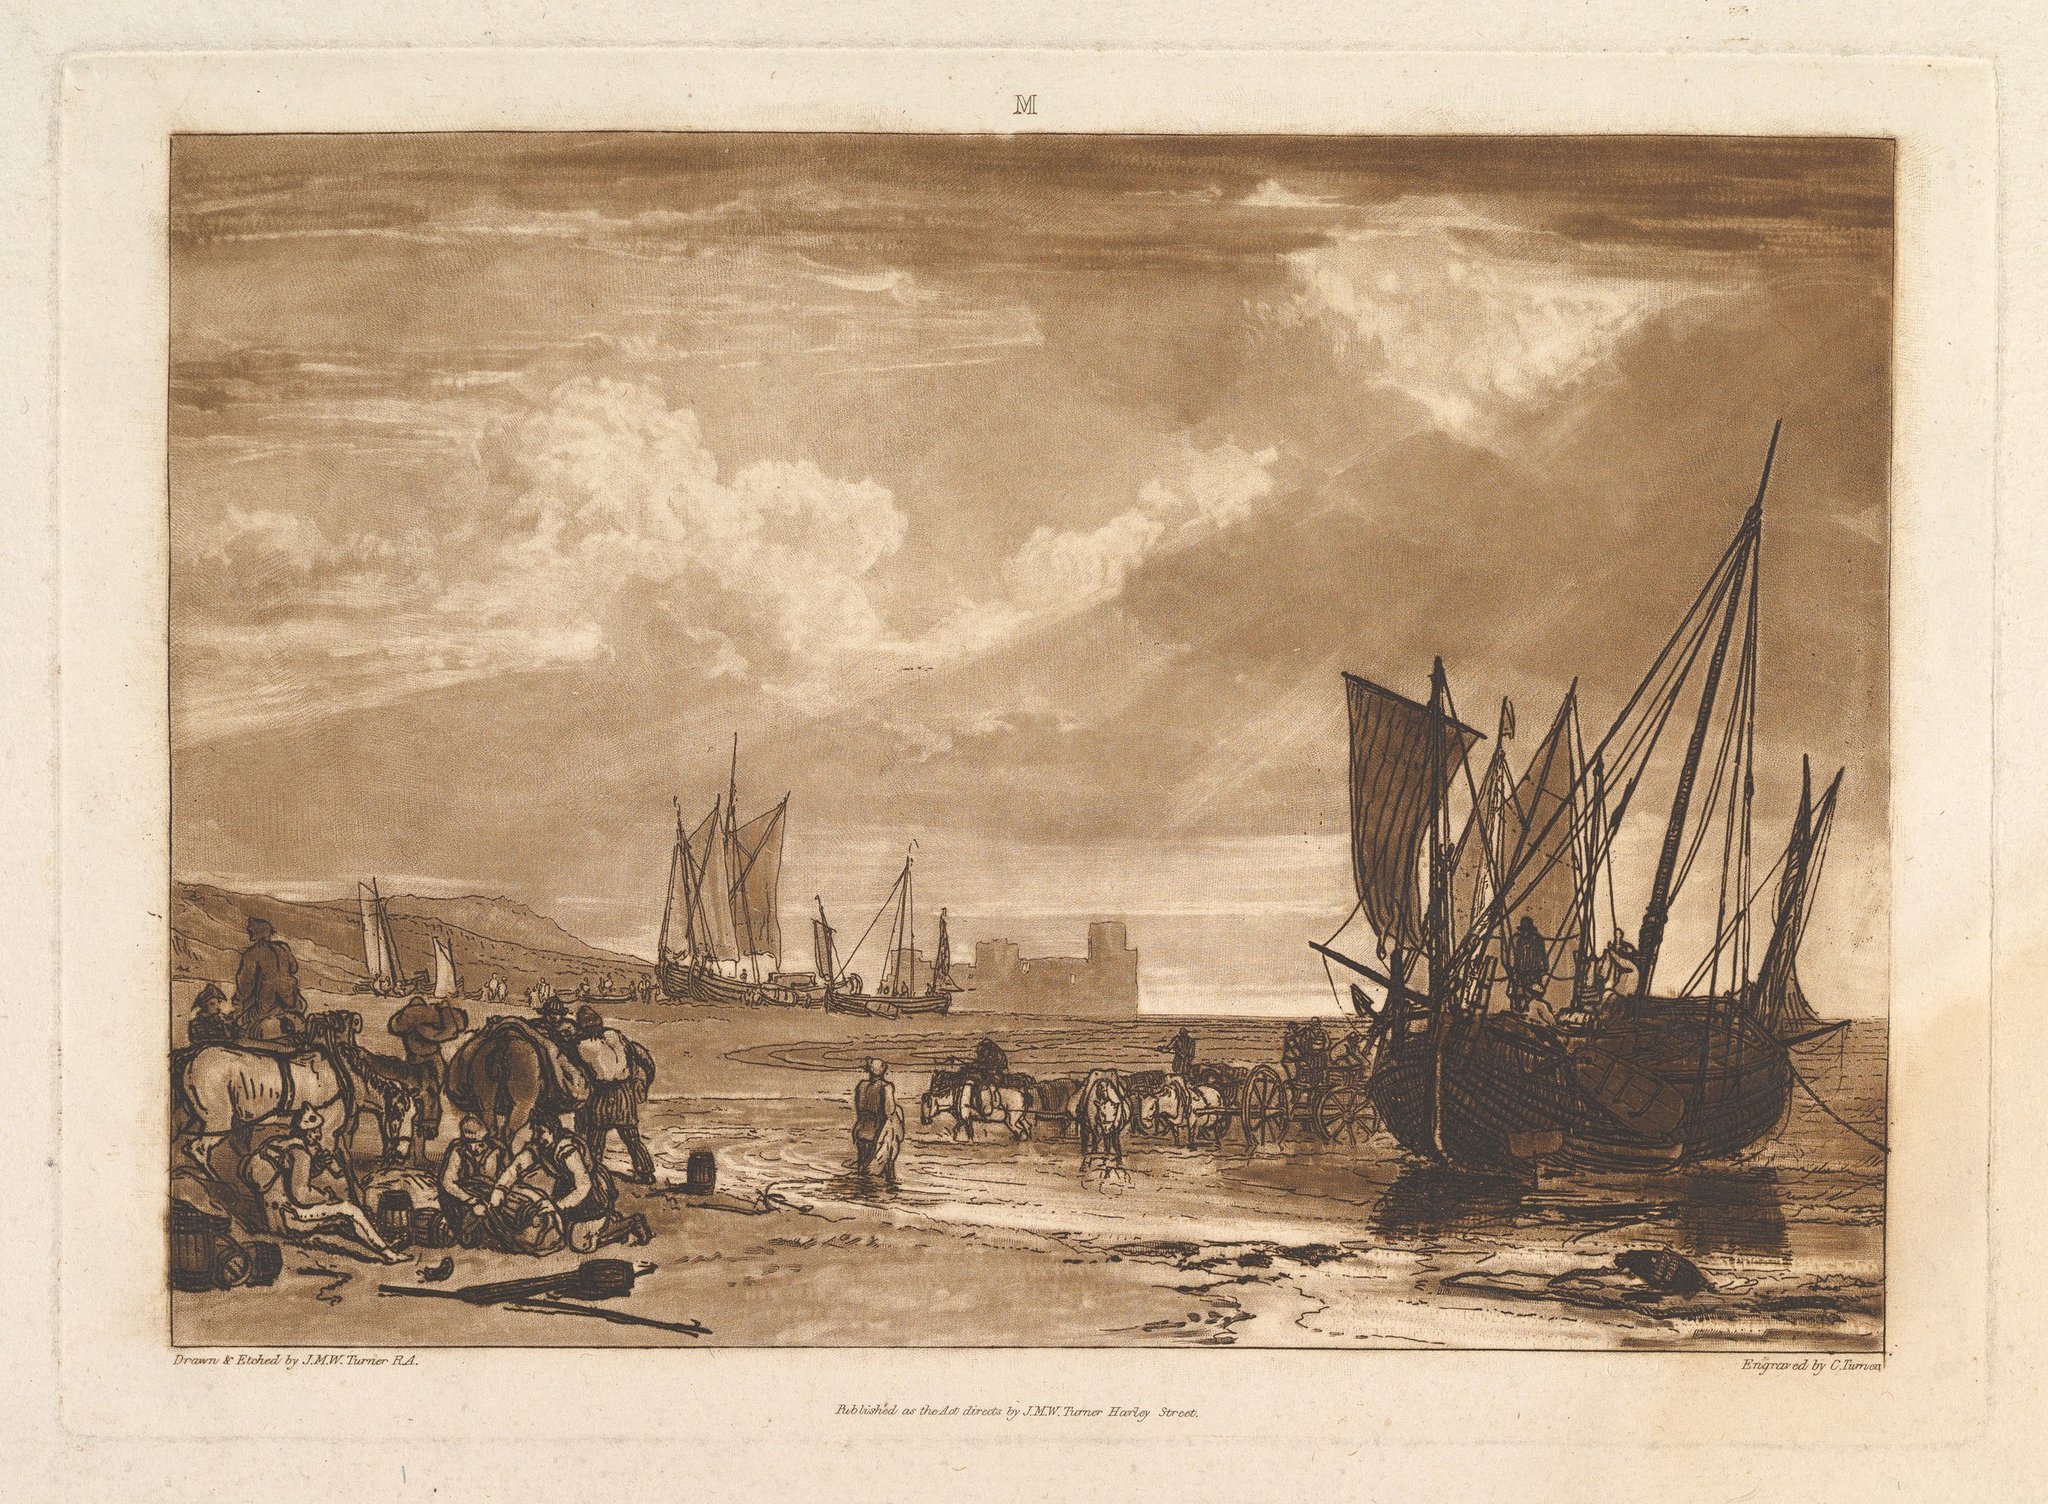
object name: print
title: Scene on the French Coast (Liber Studiorum, part I, plate 4)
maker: joseph mallord william turner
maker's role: artist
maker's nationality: british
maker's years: 1775-1851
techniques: etching, mezzotint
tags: horses,ships